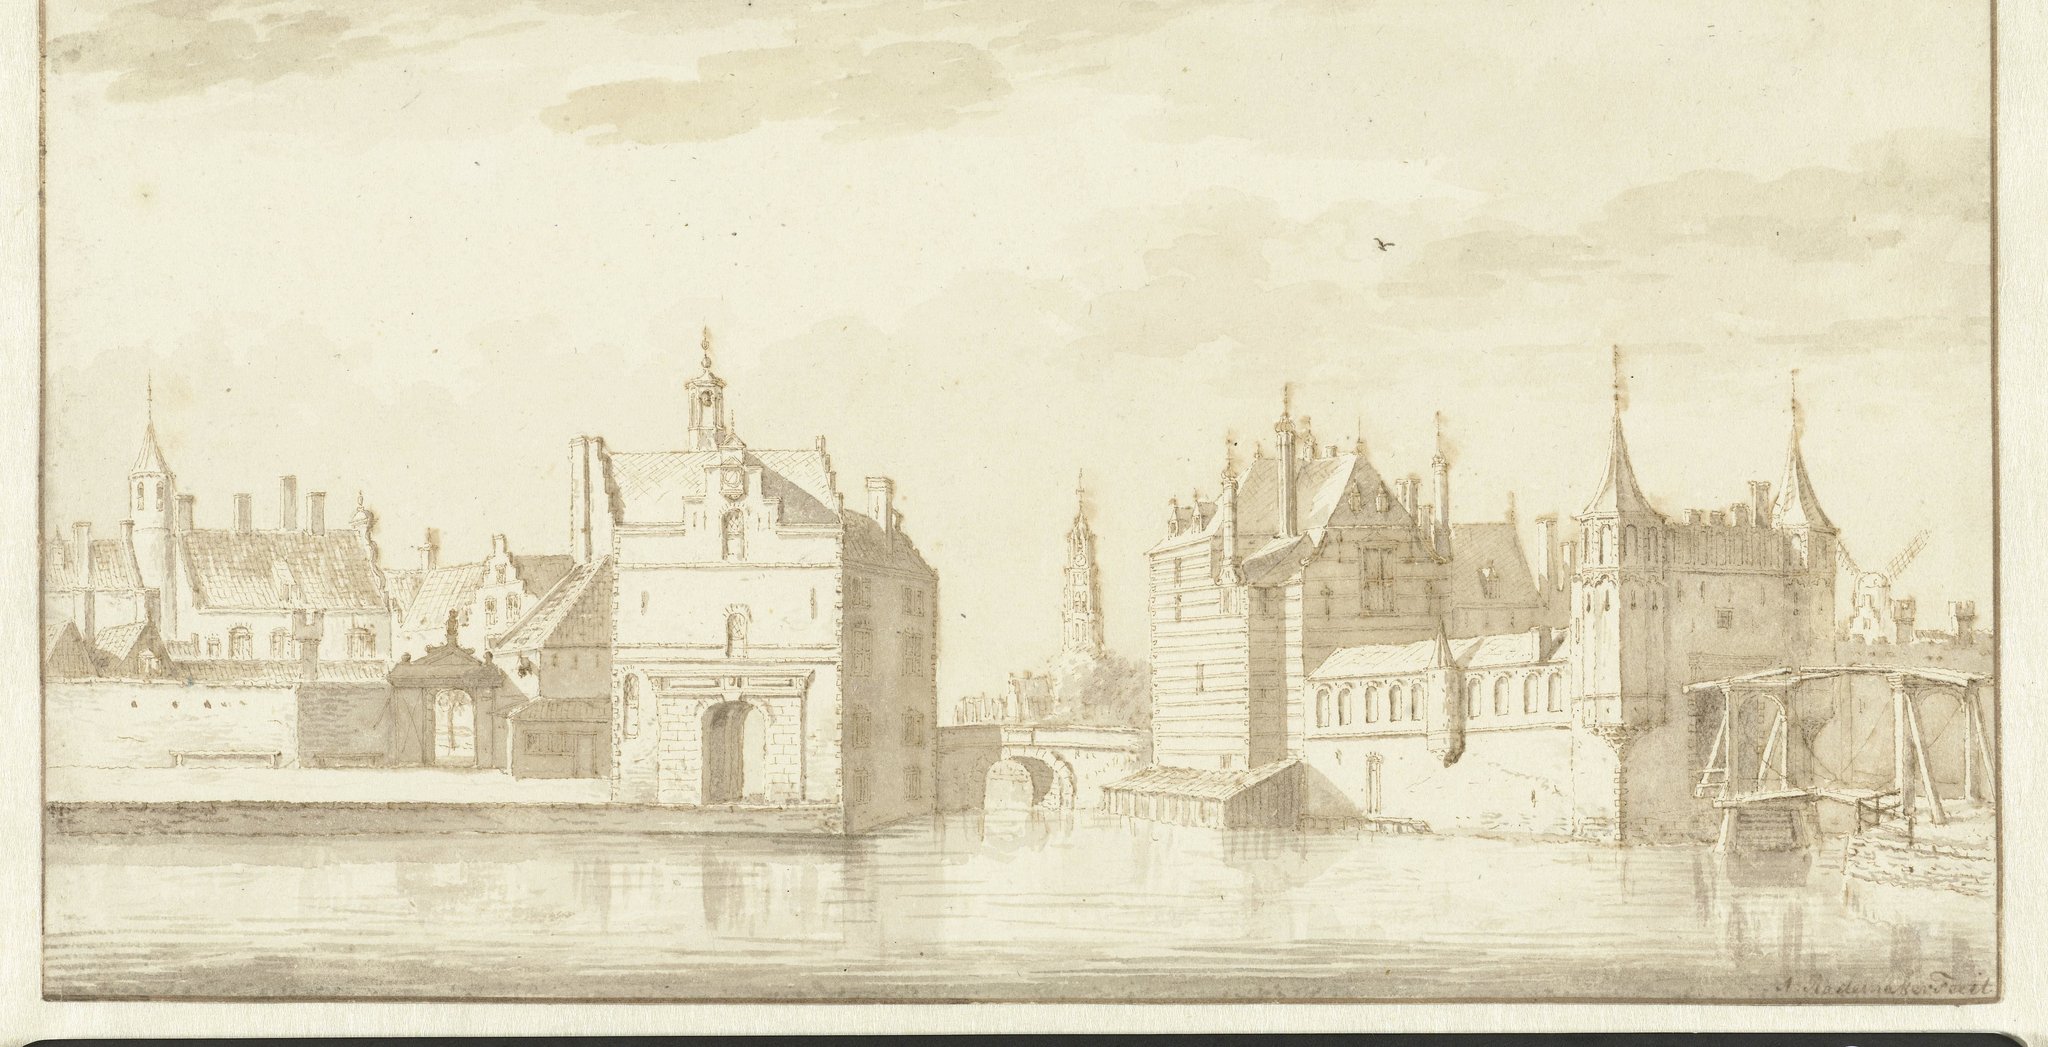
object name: drawing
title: Gezicht op de Ketelpoort en de Rotterdamse Poort te Delft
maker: abraham rademaker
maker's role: draughtsman, print maker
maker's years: 1676-1735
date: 1685-1735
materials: ink, paper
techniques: brush, pen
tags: city-walls, prospect of city, town panorama, silhouette of city, delft